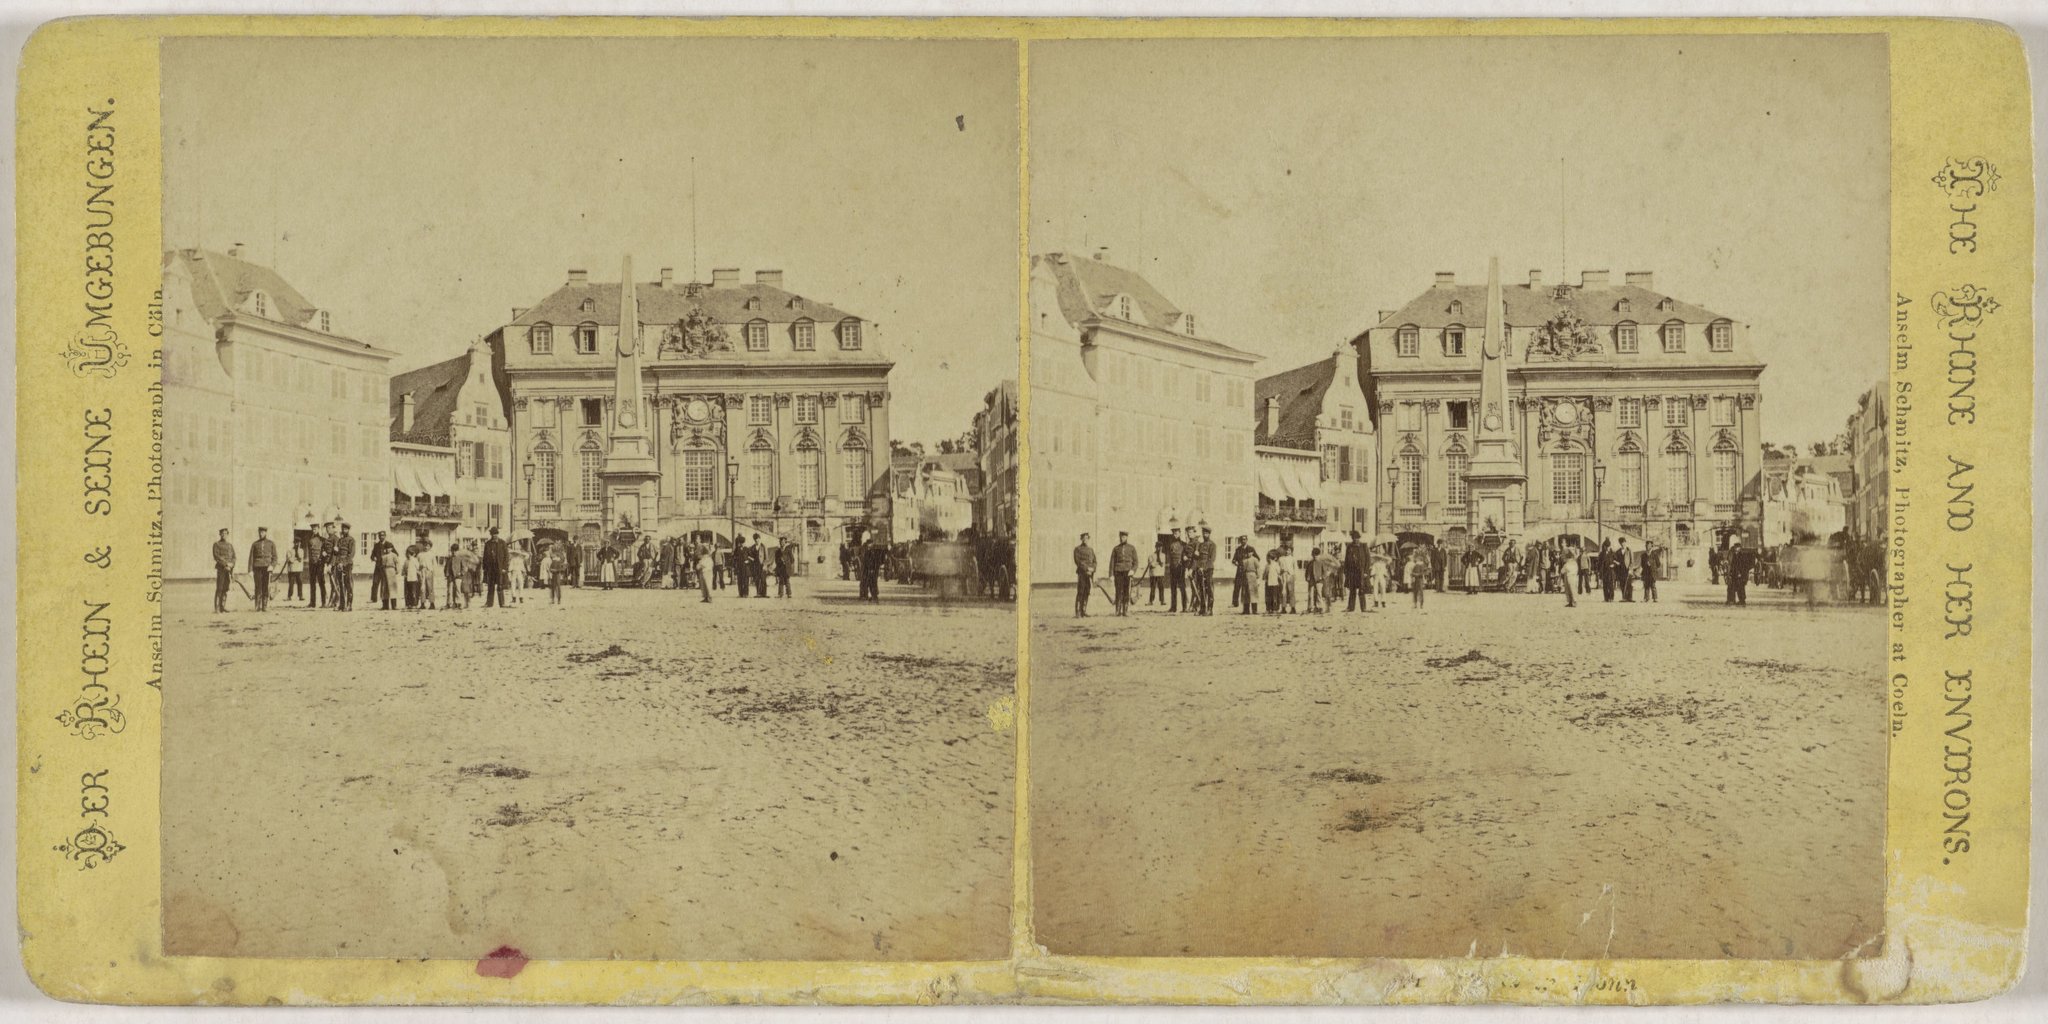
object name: stereograph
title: Marktplein met de marktfontein in Bonn, Duitsland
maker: anselm schmitz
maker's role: publisher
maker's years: 1831-1903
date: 1880-1890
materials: cardboard, paper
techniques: albumen print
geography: bonn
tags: square, place, circus, etc., townhall, ornamental fountain